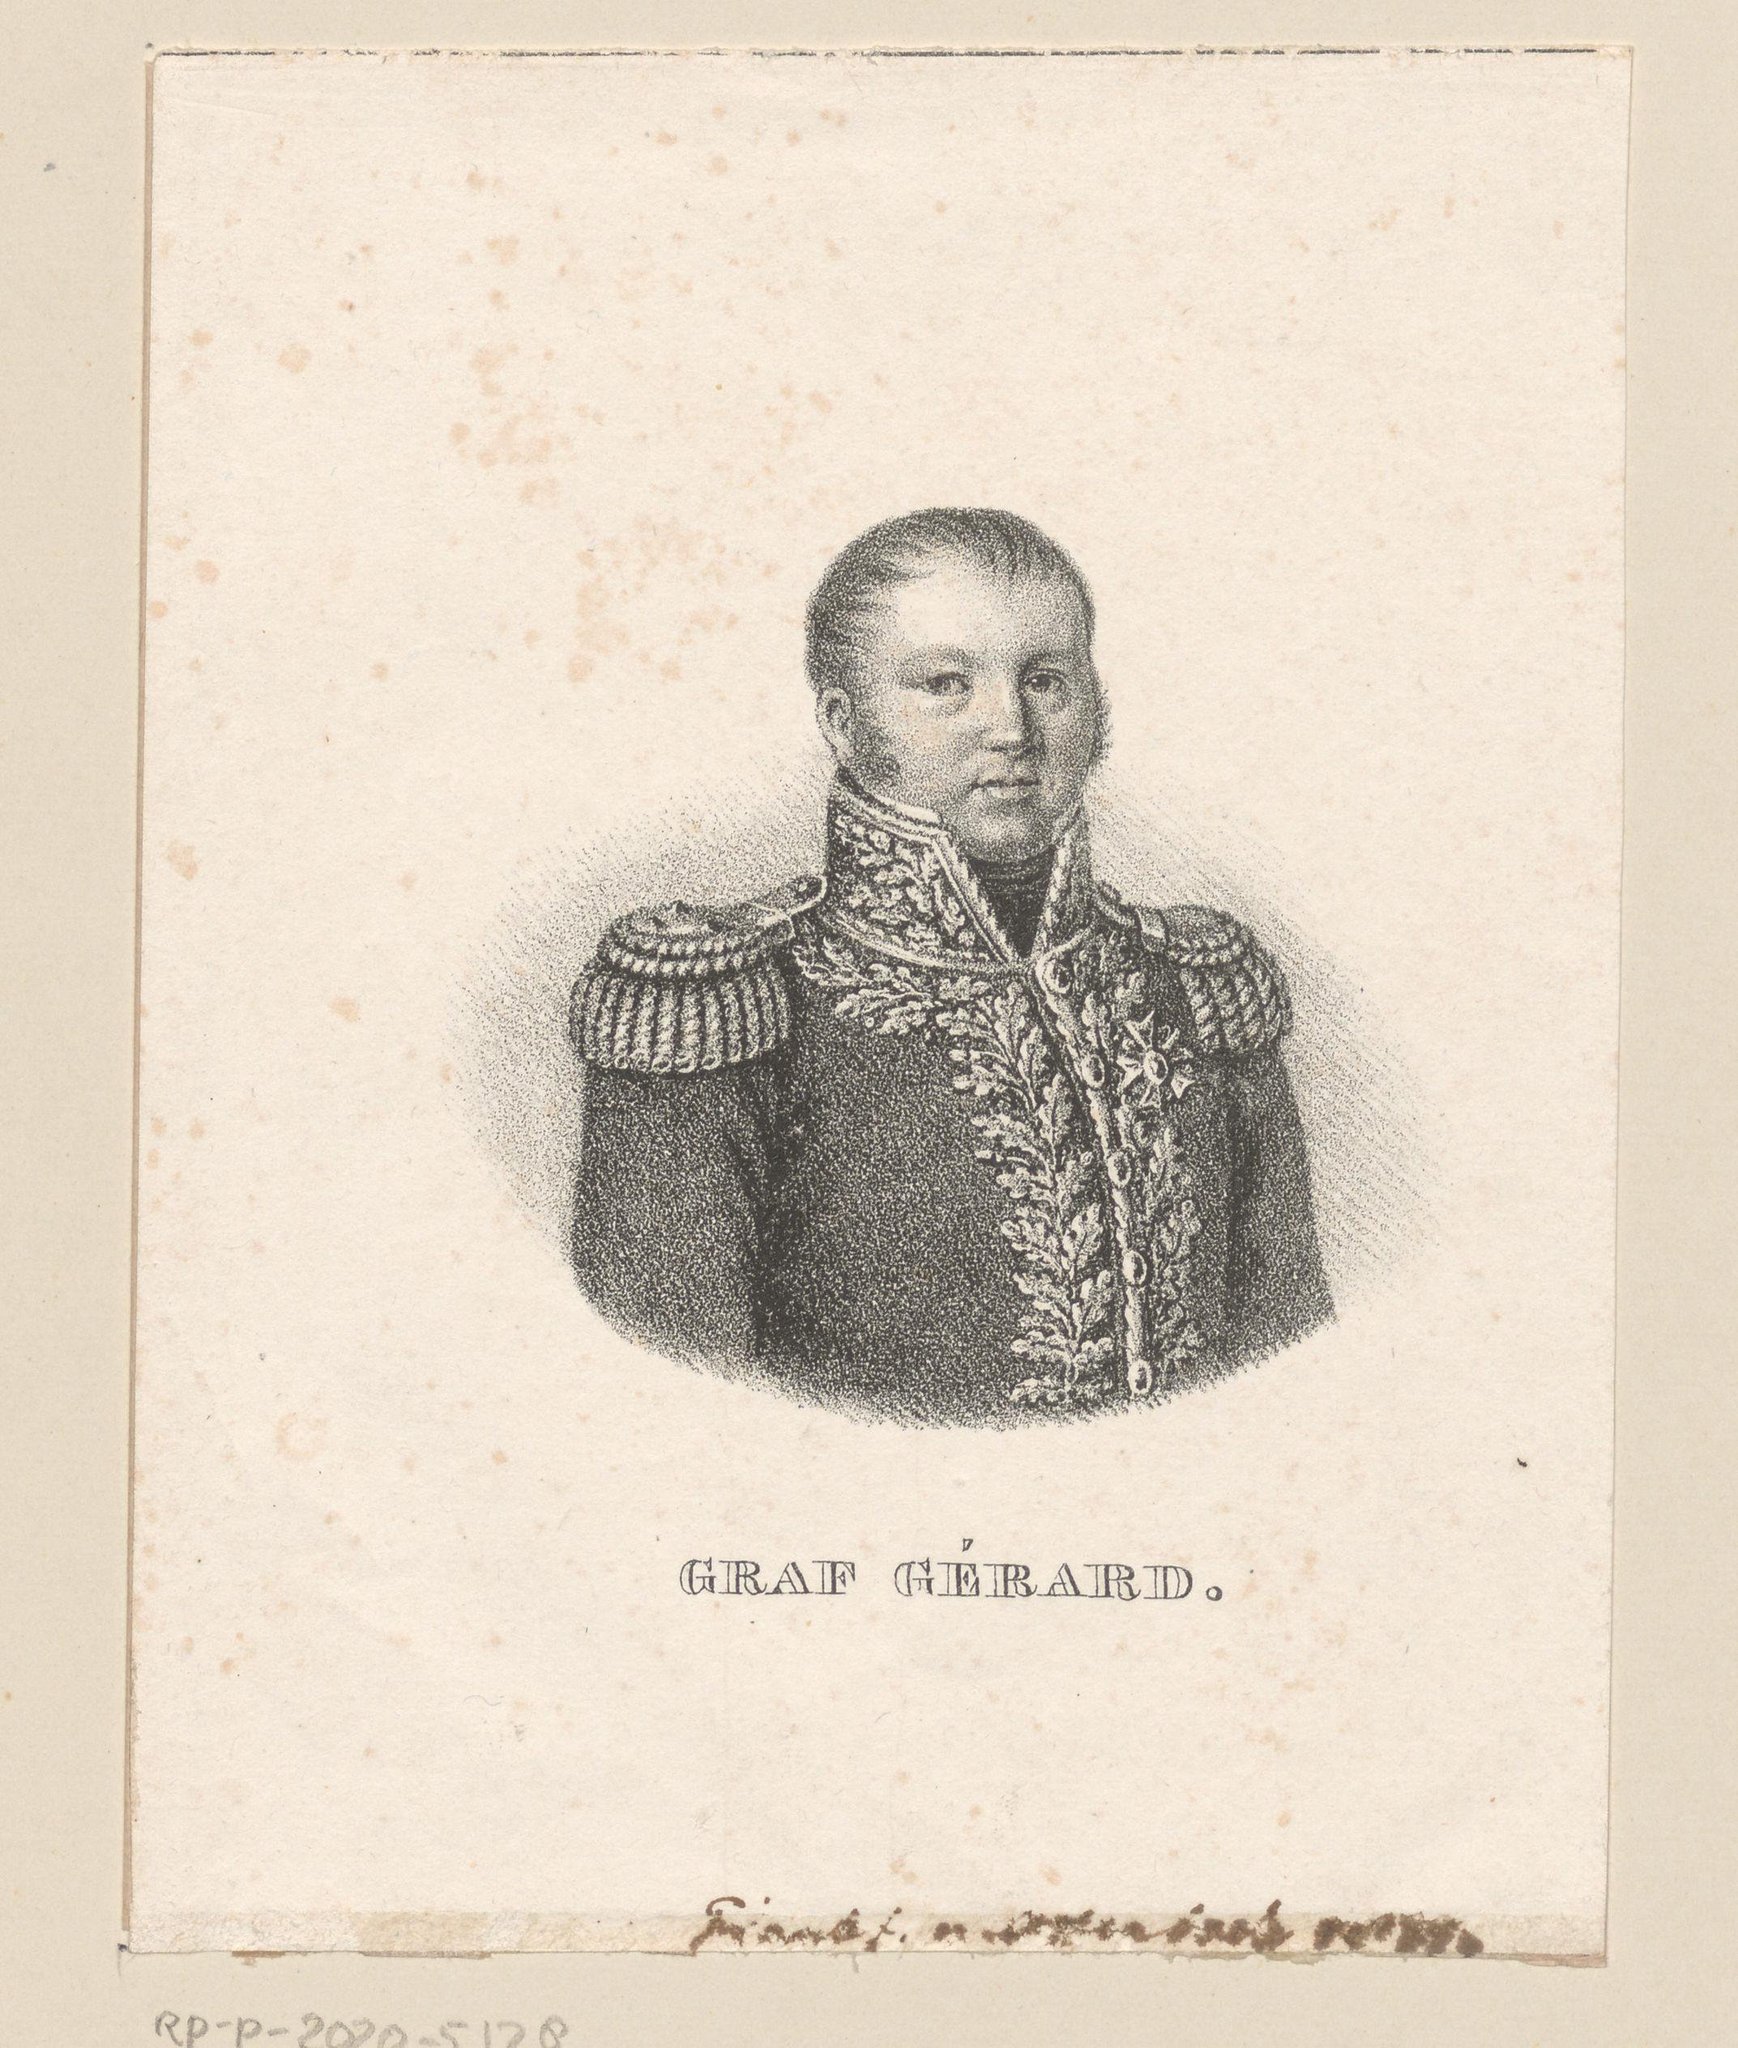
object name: print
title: Portret van Étienne Maurice Gérard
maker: Anonymous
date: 1813-1856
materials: paper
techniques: stippling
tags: commander-in-chief, general, marshal, historical persons